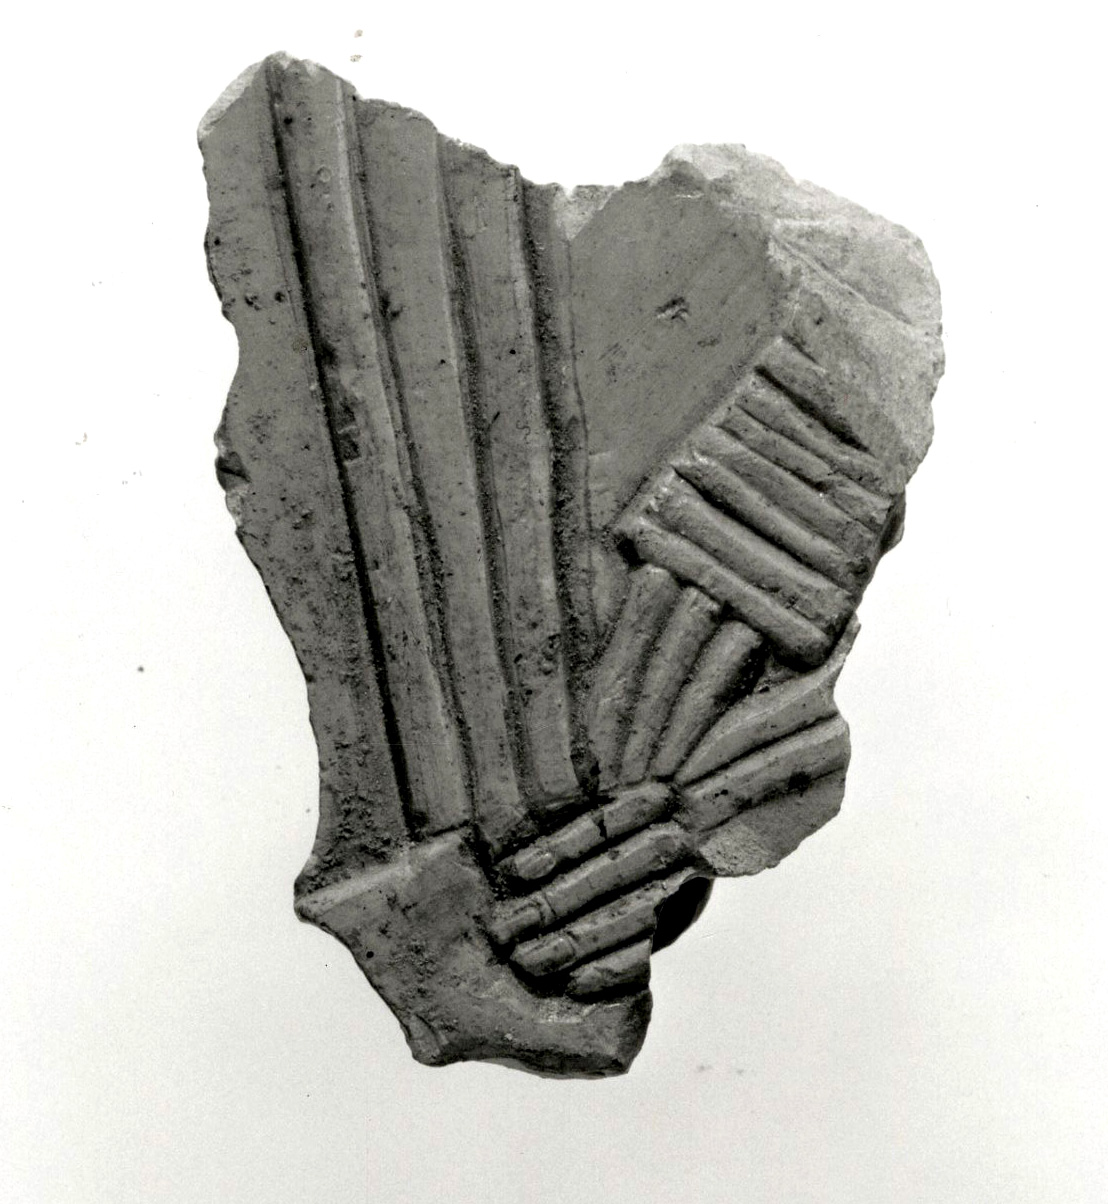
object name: relief, tomb of nespekashuty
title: Raised relief fragment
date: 664-610 BCE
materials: limestone, varnish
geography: egypt